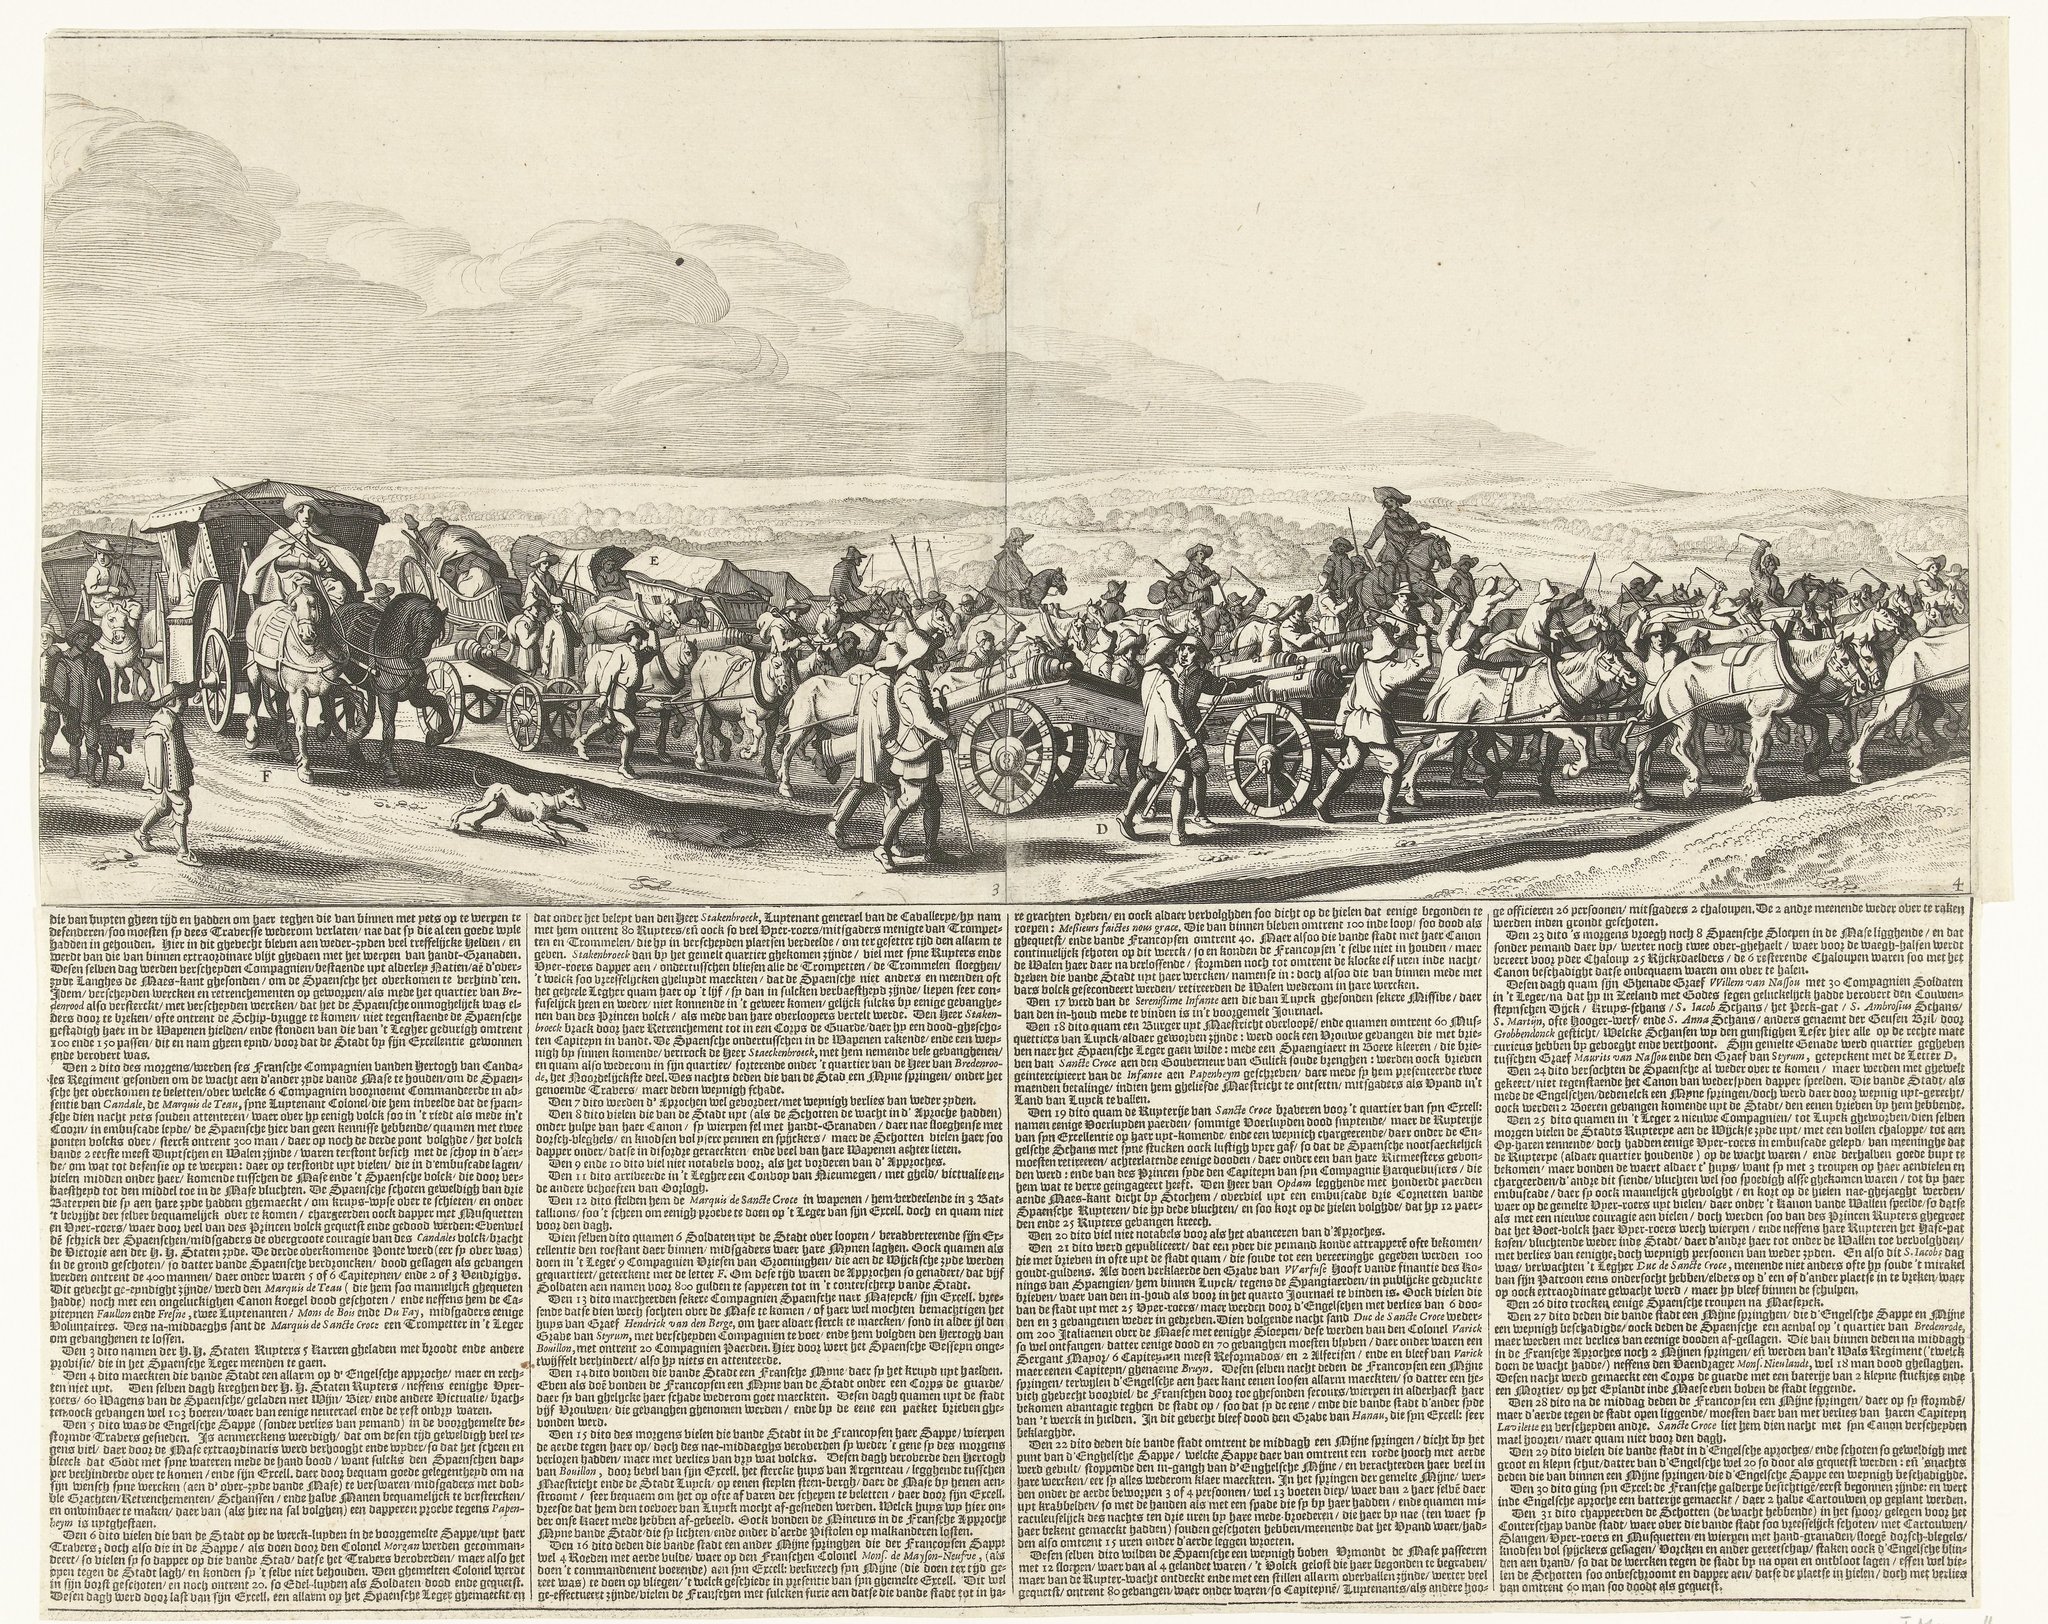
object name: print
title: Discessus Hispanici Praesidii Trajecti ad Mosam Ao. 1632. Die 23 Augusti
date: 1633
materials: paper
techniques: etching, letterpress printing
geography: northern netherlands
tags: frederick henry (prince of orange), retreat of the defeated, maastricht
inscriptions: date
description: Uittocht van het Spaanse leger uit Maastricht, 23 augustus 1632. Fries van zes genummerd platen, platen nrs. 3 en 4 aan elkaar geplakt. Rijtuigen, wagens en artillerie in de stoet van vertrekkende soldaten. Onder elk van de platen tekst in twee kolommen in het Nederlands.